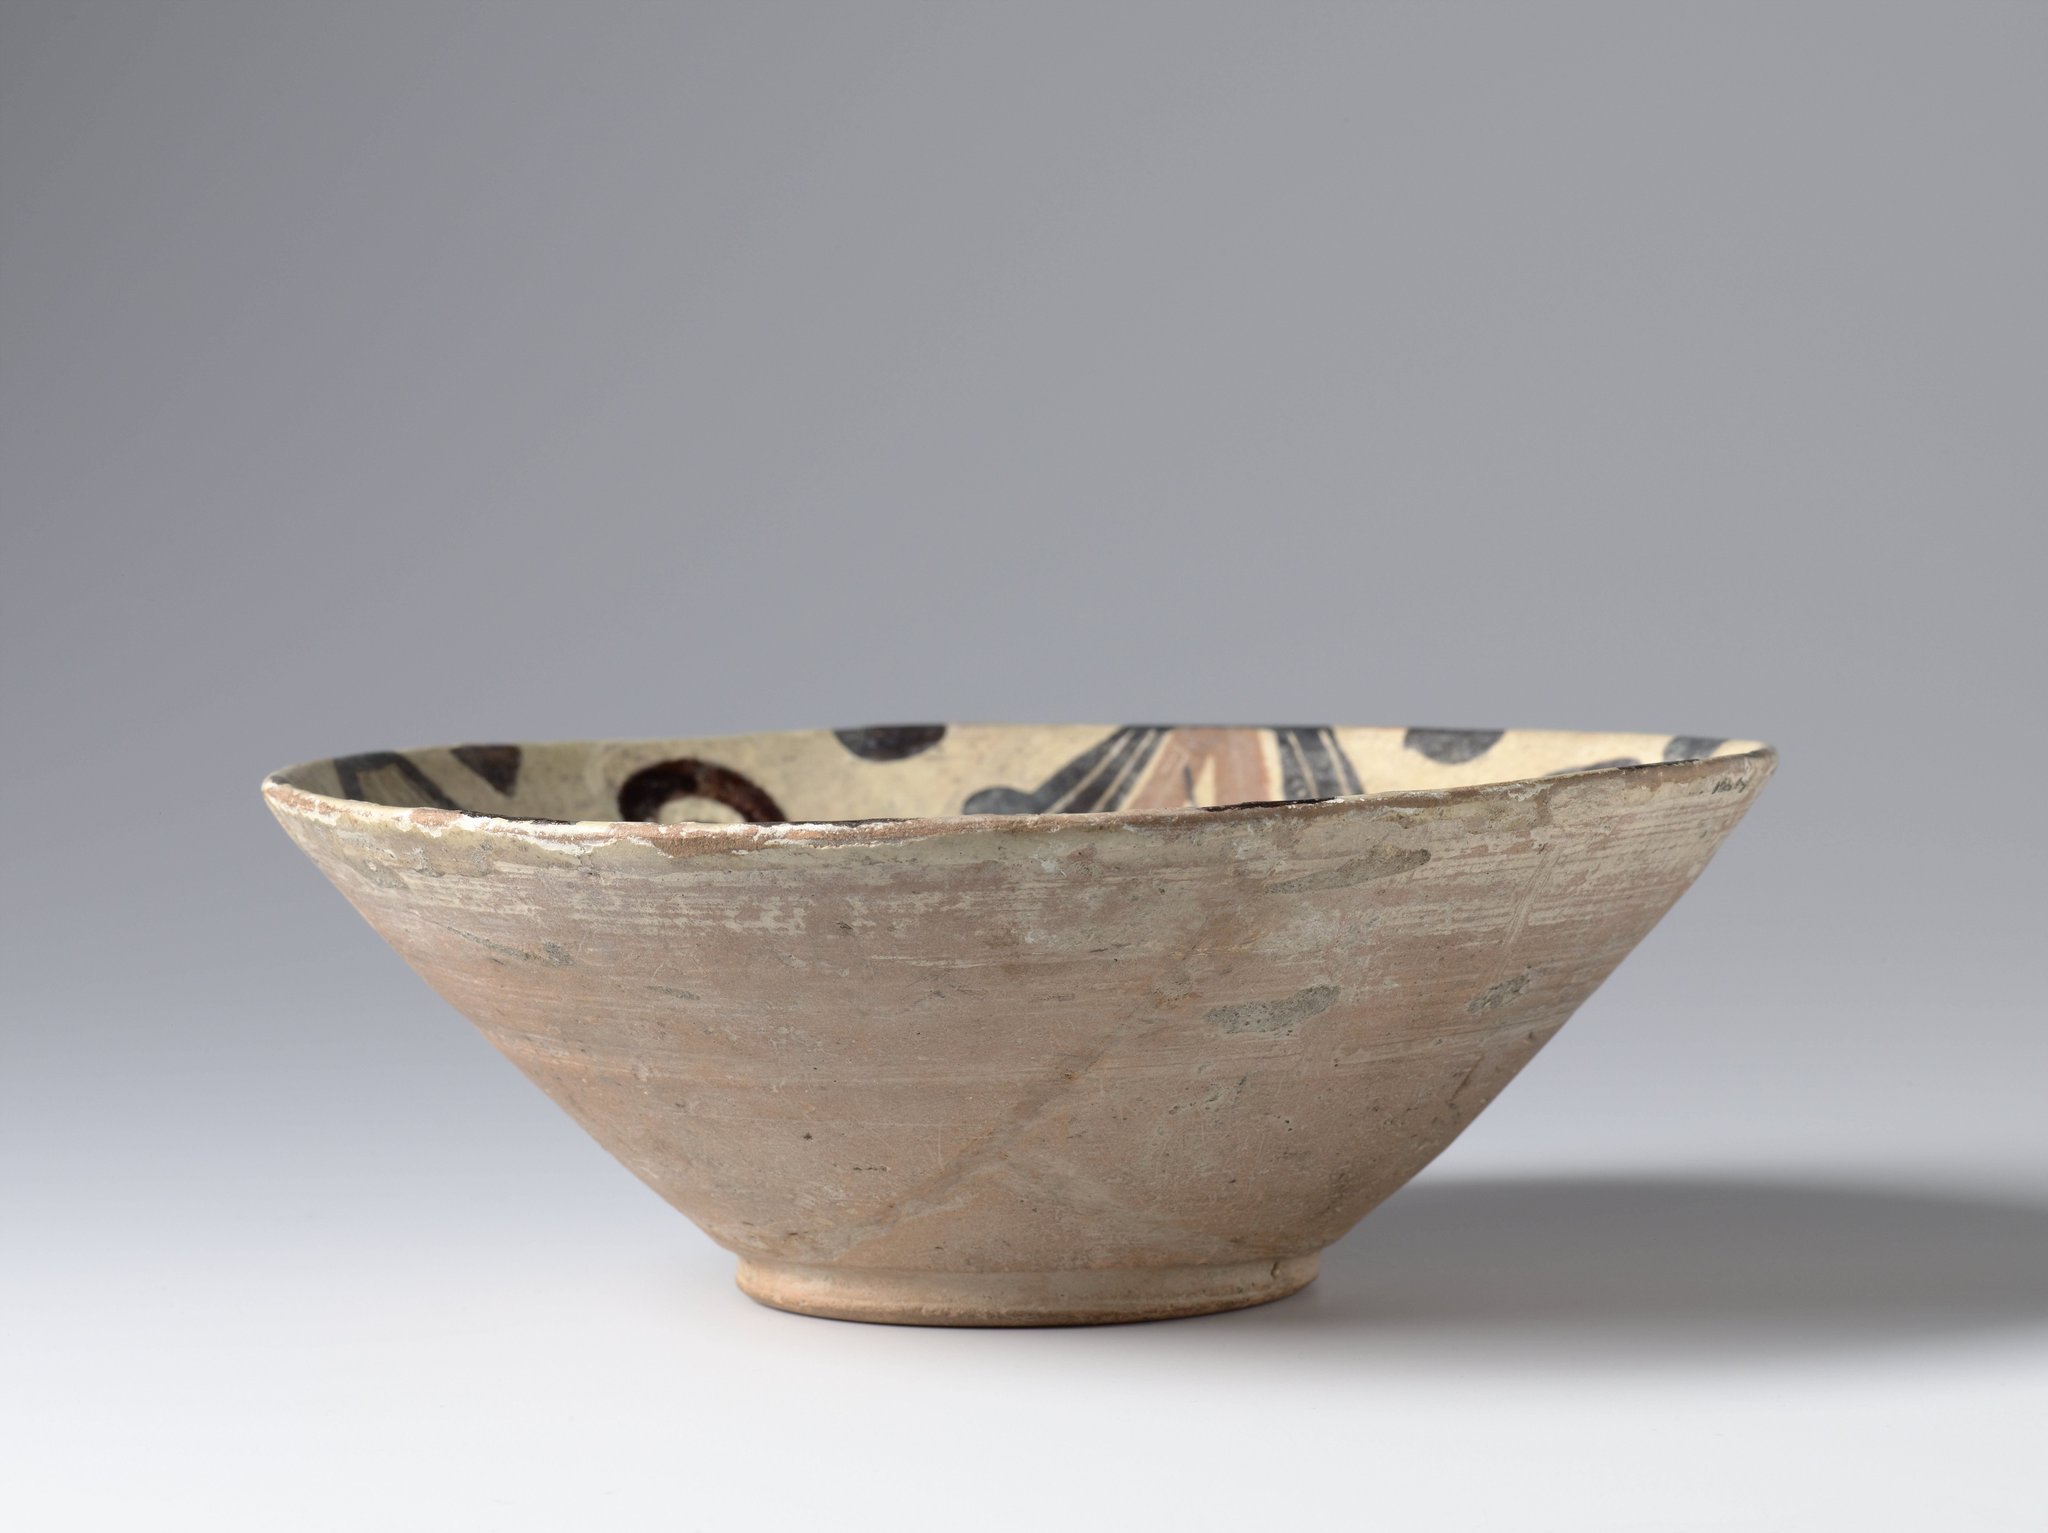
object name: bowl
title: Bowl with stylized flower sprays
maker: Anonymous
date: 900-1099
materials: earthenware, glaze, paint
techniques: firing, turning, vitrification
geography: sari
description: Kom van aardewerk gedecoreerd met mangaanzwarte, roodbruine en groenige slib, met enkele incisies door kleuren heen, op engobe van witte slib. Op de binnenzijde gestileerde bloemtakken.